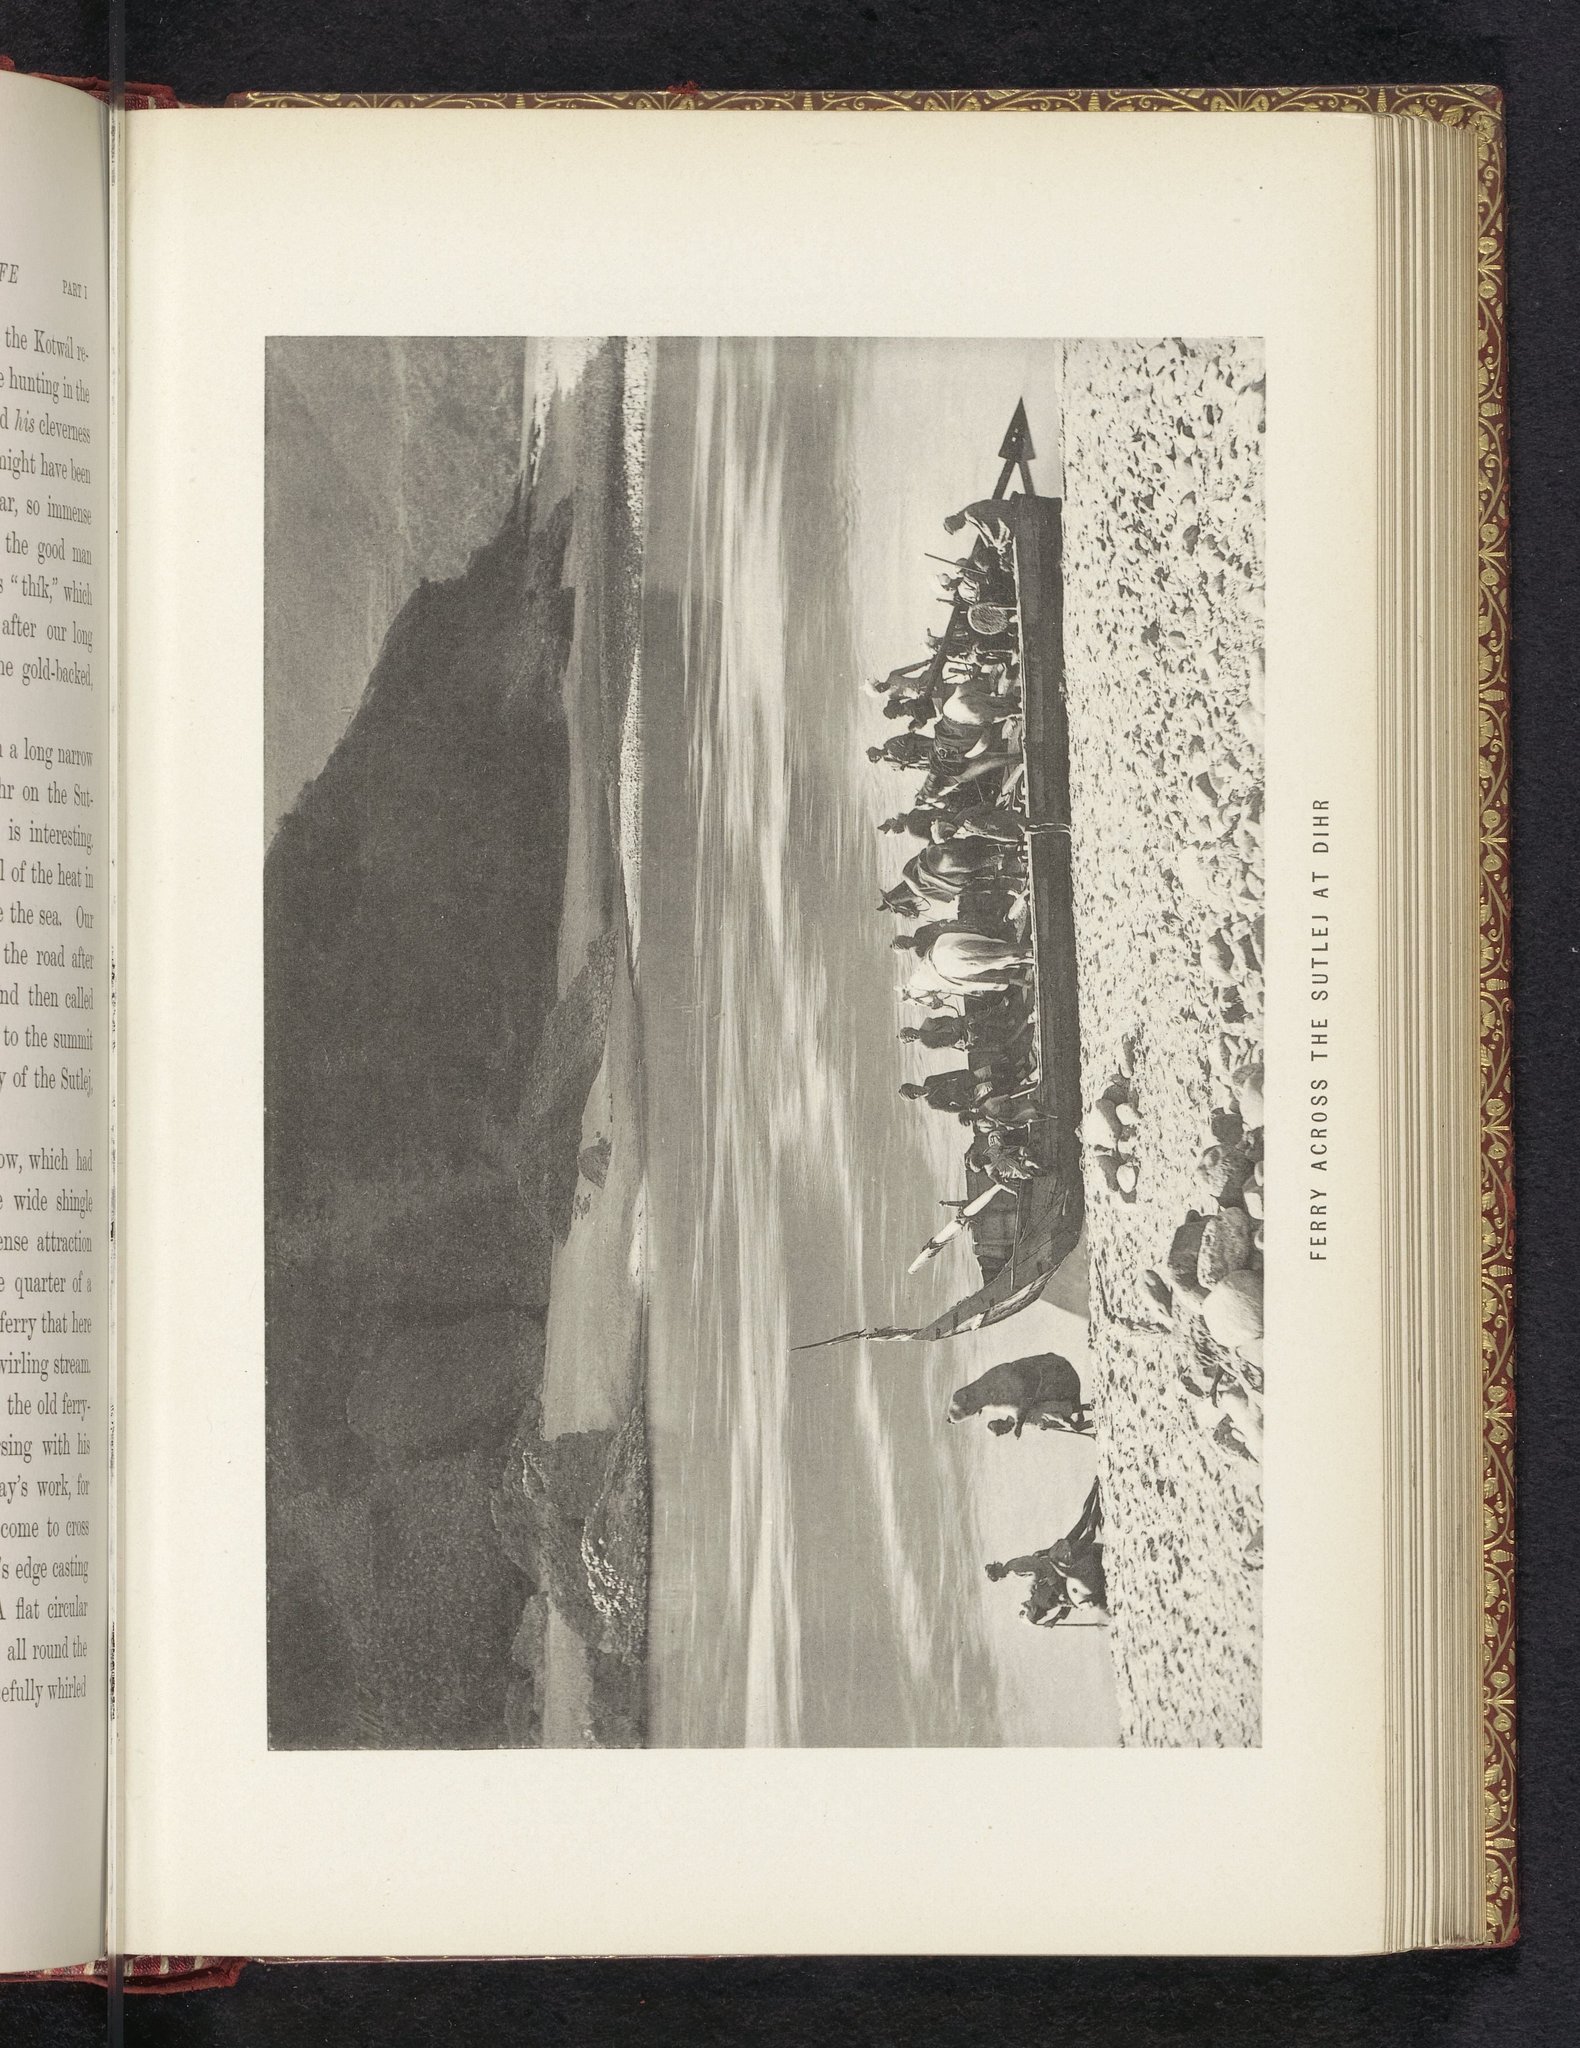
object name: page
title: Ferry across the Sutlej river near Bilaspur in Himachal Pradesh, India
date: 1890-1895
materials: paper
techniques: photograph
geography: bilaspur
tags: river, ferry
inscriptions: caption: ‘FERRY ACROSS THE SUTLEJ AT DIHR’